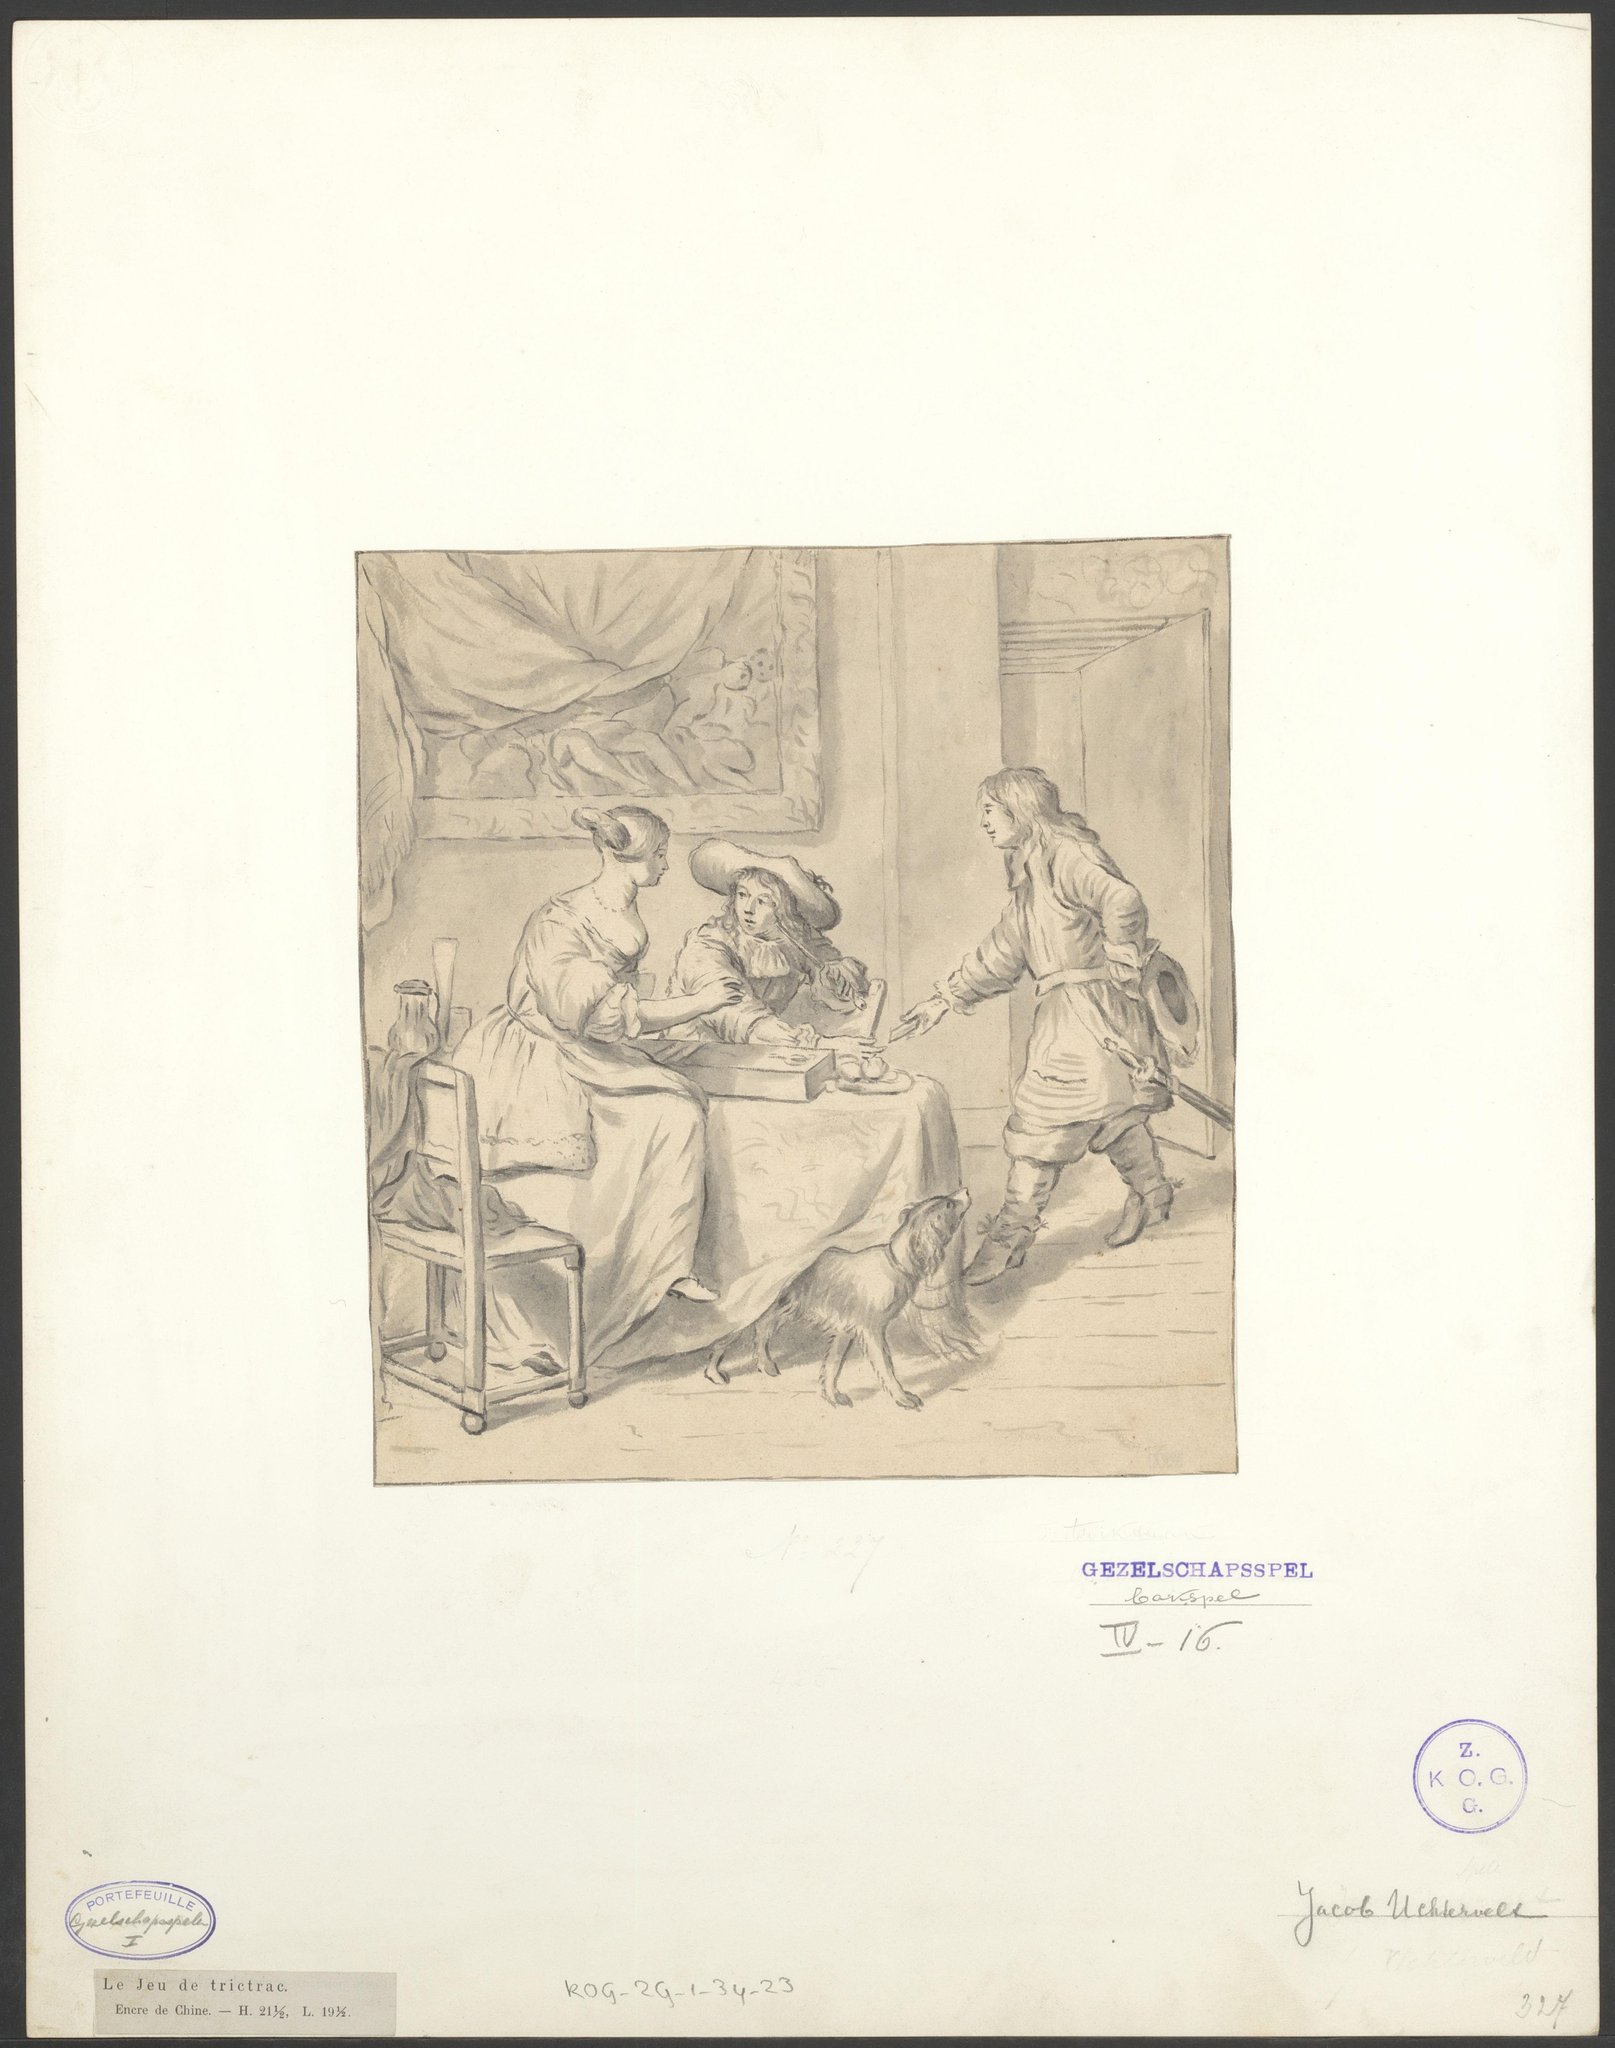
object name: drawing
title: Interieur met twee spelers bij een bakspel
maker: jacob ochtervelt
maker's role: painter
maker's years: 1634-1682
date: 1645-1682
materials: ink, paper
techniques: brush, pen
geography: netherlands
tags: backgammon, tric-trac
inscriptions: collector's mark: Lugt 1641, collector's mark: Lugt 2643, collector's mark: